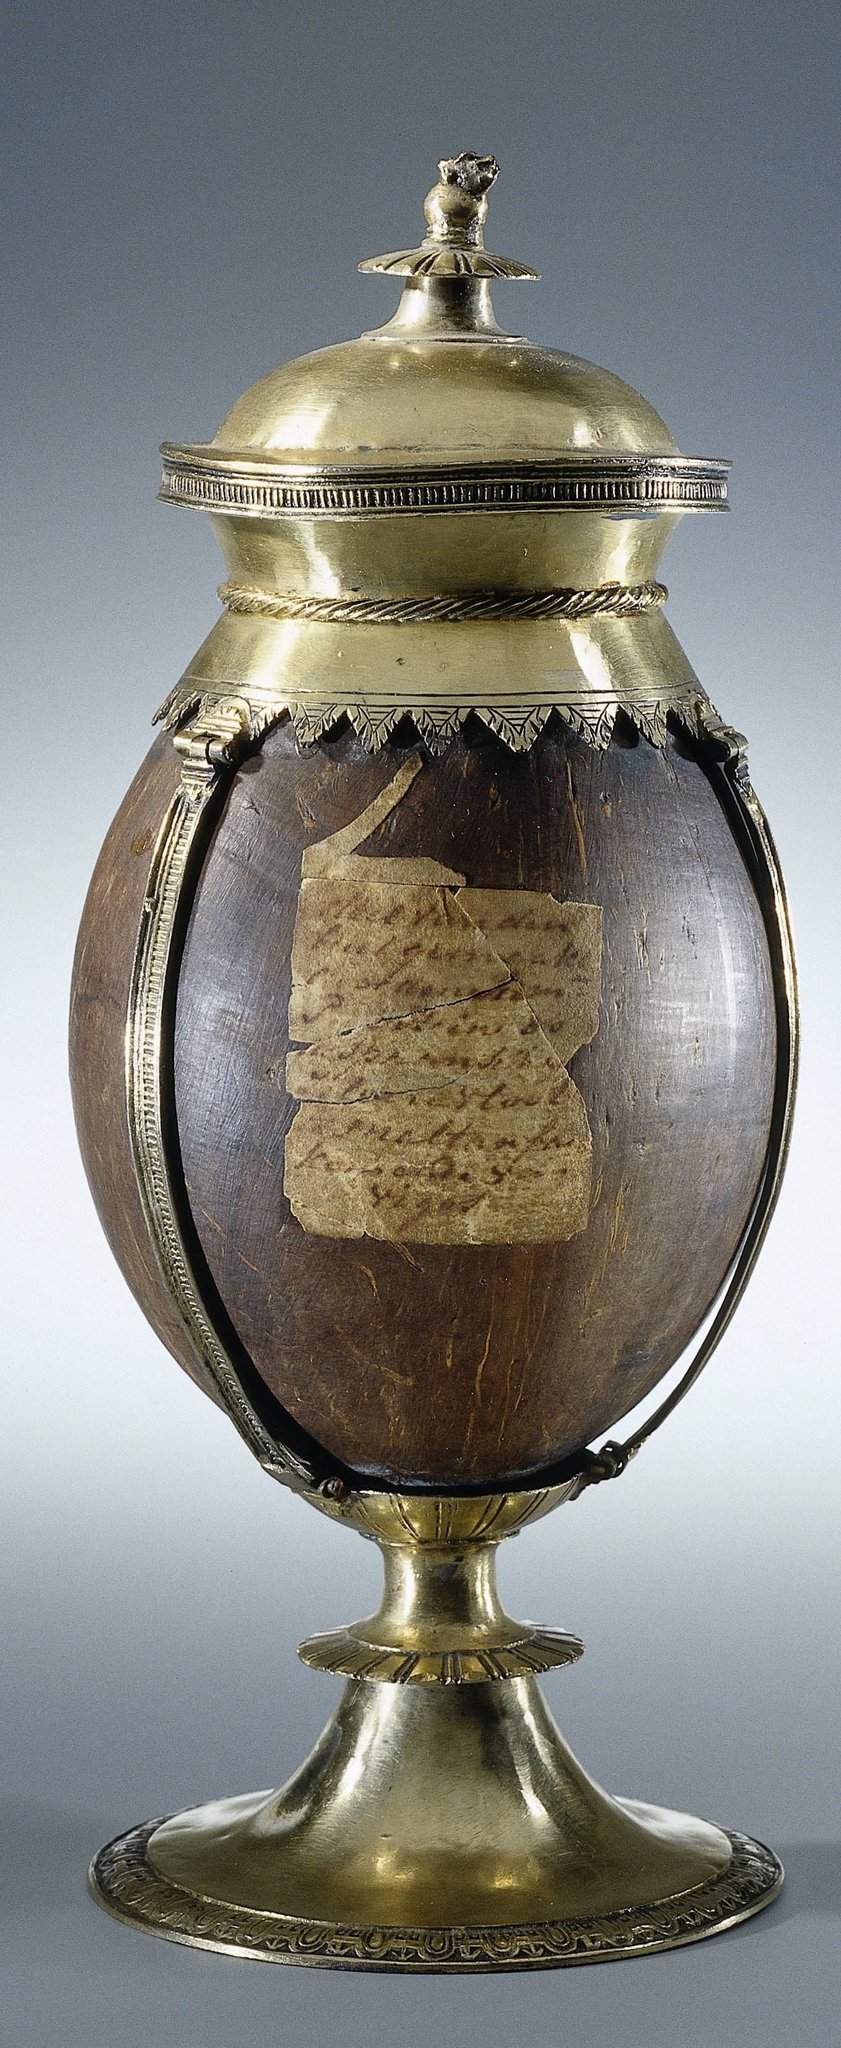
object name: cup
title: Kokosnootbeker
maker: Anonymous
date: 1585-1600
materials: plant material, gourd, silver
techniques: gilding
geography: germany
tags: delfshaven, capture of the spanish treasure fleet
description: In September 1628 Piet Heyn surprised the Spanish treasure fleet off Cuba. The Spanish ships were loaded with silver and valuable objects from Mexico and Peru. A percentage of the enormous prize went to the government and was used to finance the war against Spain. Piet Heyn commanded a squadron of the Dutch West India Company (WIC).